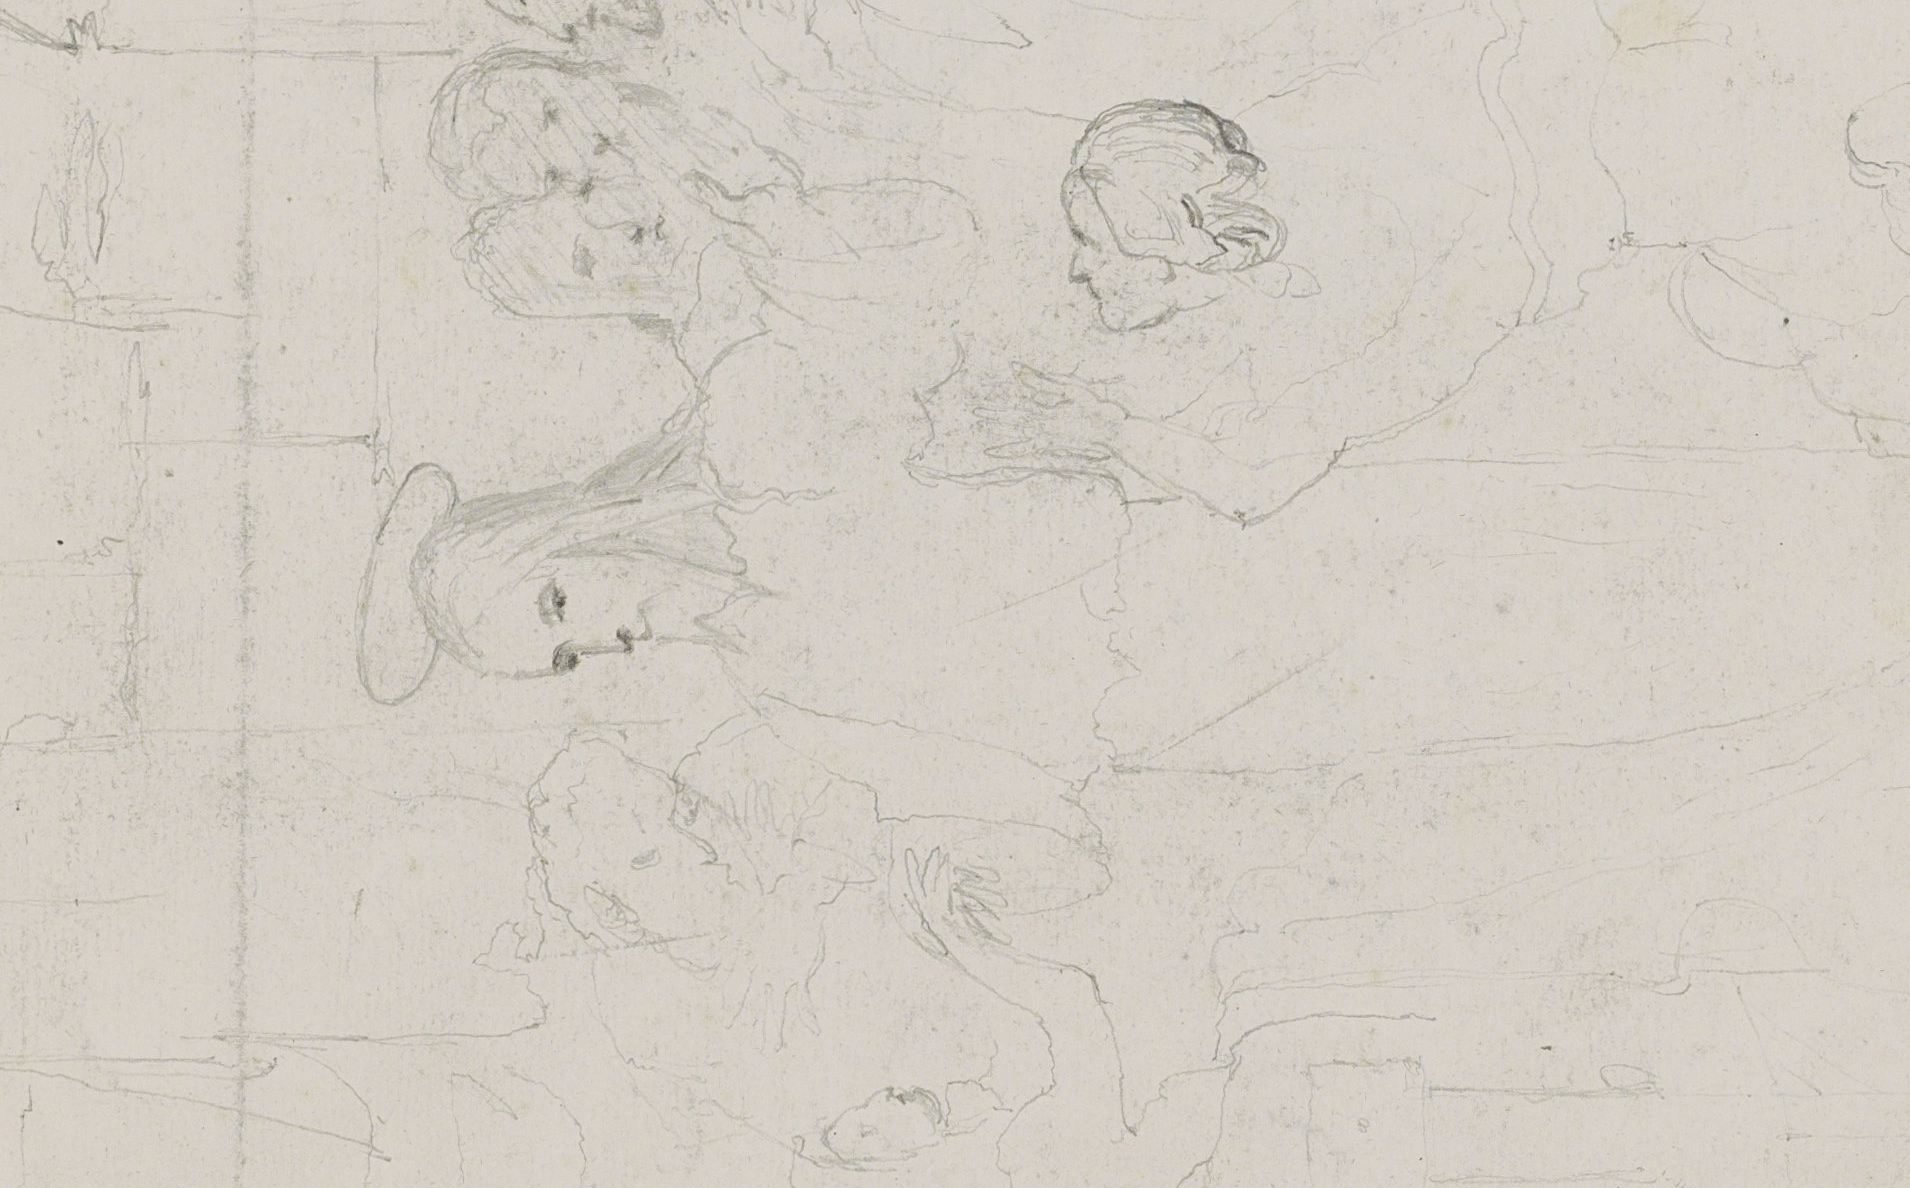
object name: sketchbook leaf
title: Christus geneest een jongen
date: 1858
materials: paper, pencil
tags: miracles of christ ~ healing the sick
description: Christus staat aan het bed van een jongen en houdt zijn hand vast. Achter Christus staan vier mannen. Op de grond knielt een vrouw bij Christus. Recto van een los blad tussen blad 32 en 33 uit een gecombineerd album amicorum en schetsboek met in totaal 39 bladen.